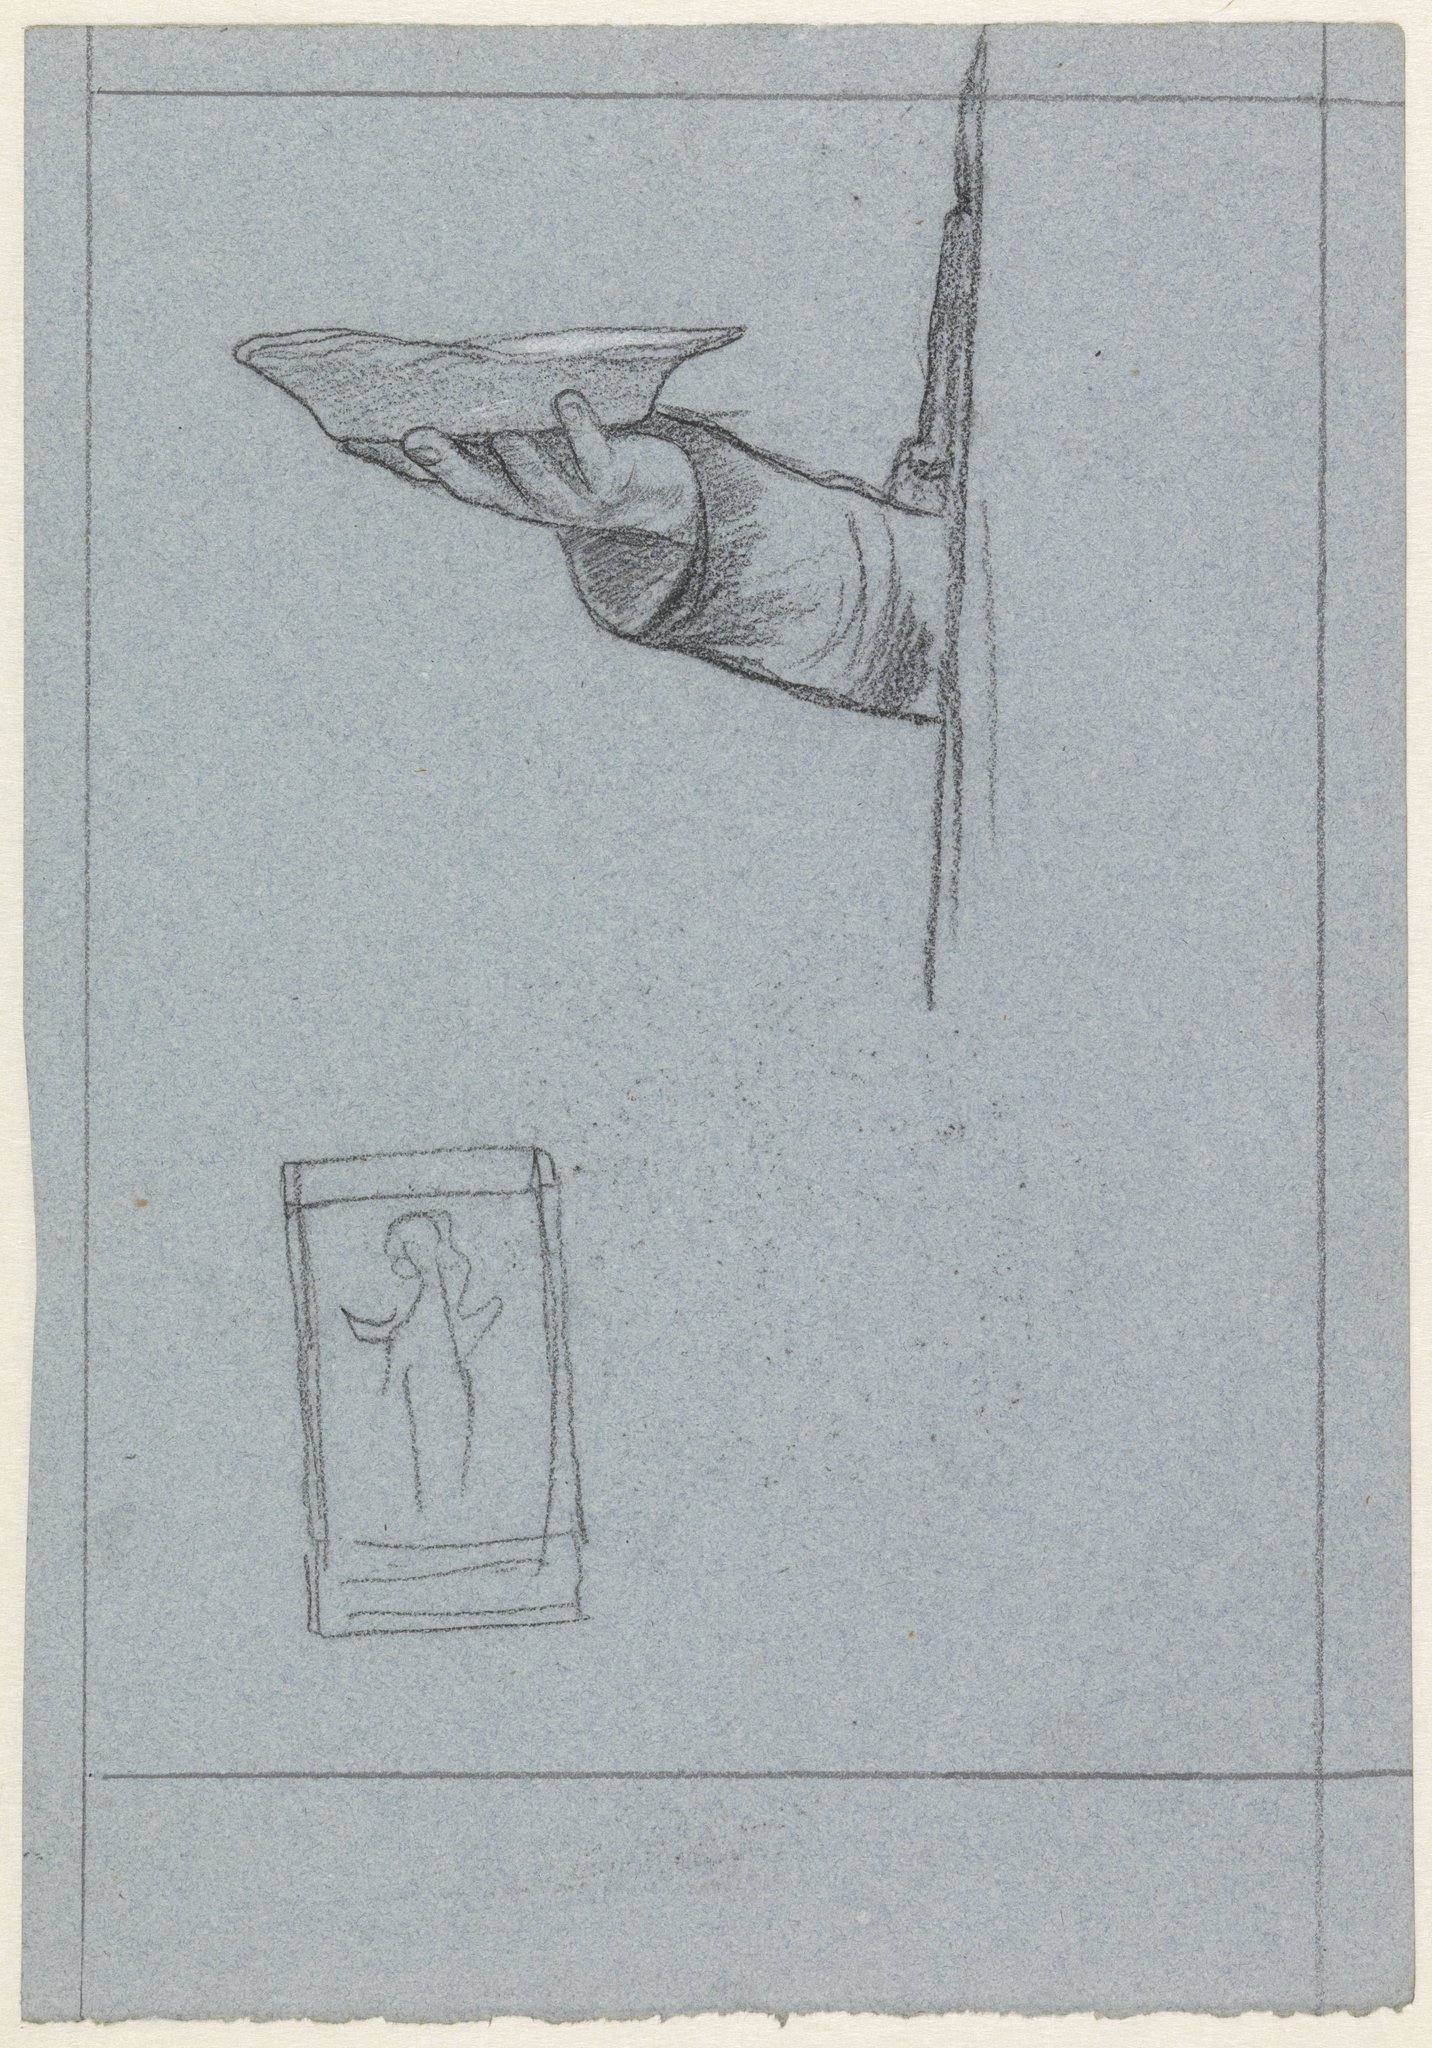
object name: drawing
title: Studie van een hand met een schaaltje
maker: jan veth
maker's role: designer, draughtsman, painter, print maker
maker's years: 1864-1925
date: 1874-1925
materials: chalk, paper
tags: hand